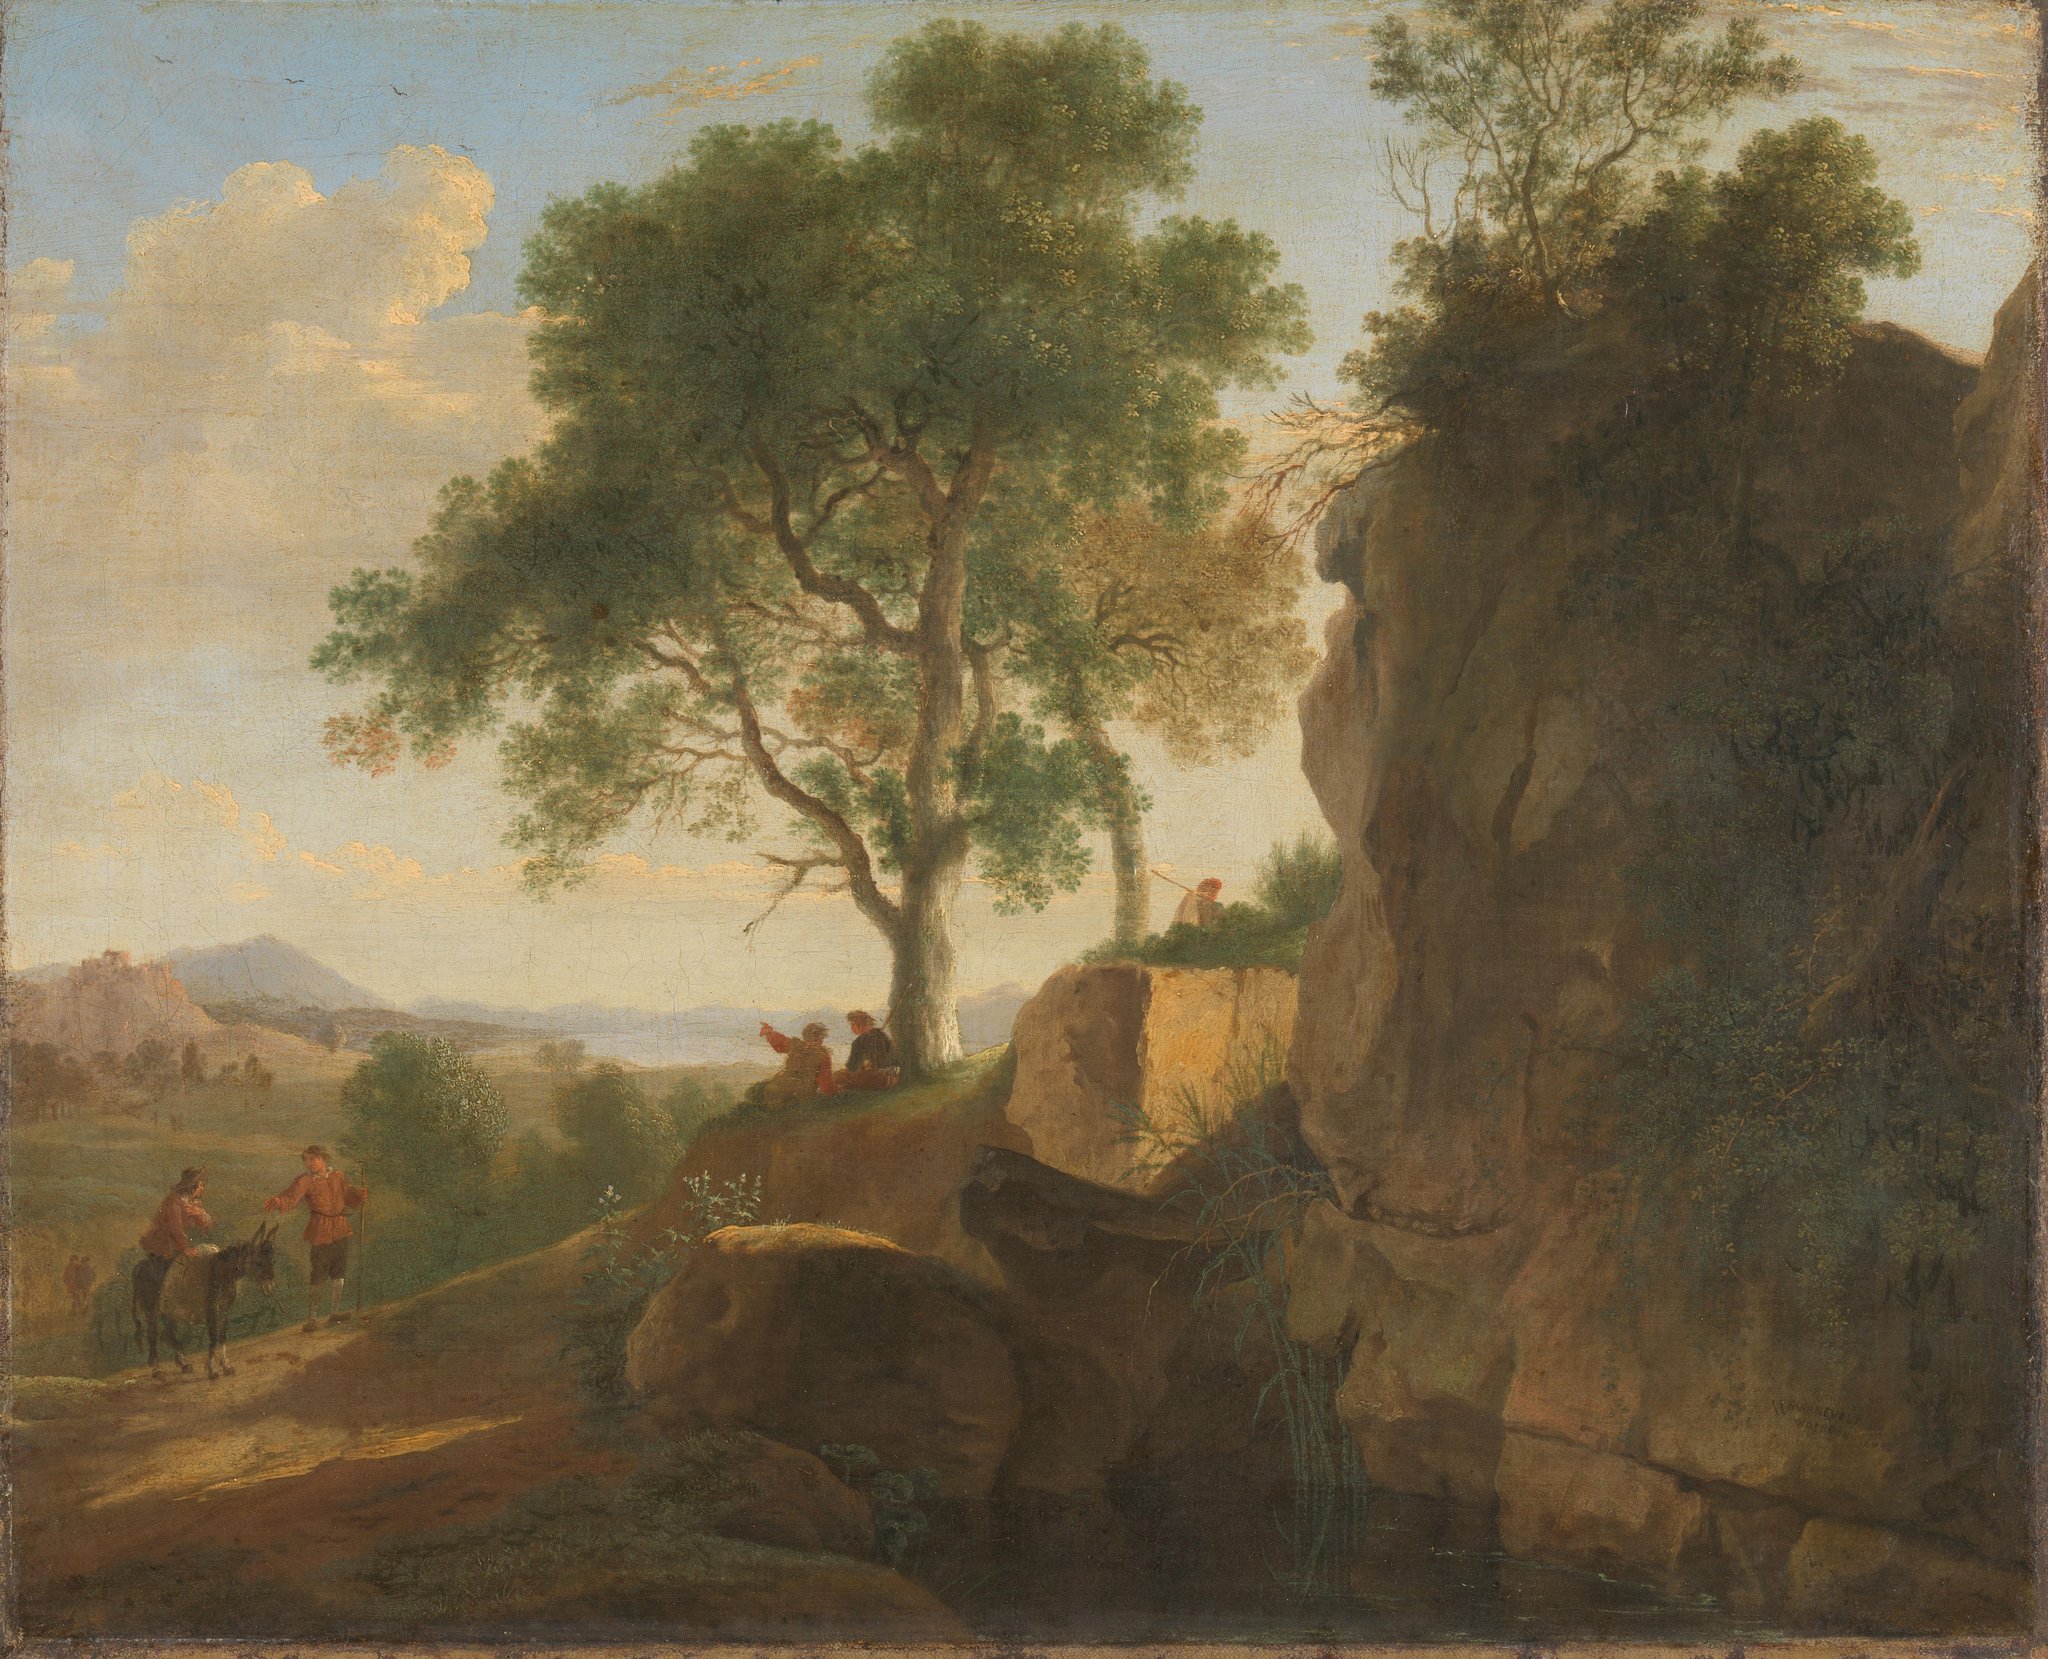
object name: painting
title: Italian landscape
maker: herman van swanevelt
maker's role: draughtsman, painter, print maker, publisher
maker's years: 1603-1655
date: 1643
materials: canvas, oil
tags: (traveller) resting in the open air, rocks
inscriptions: signature and date: ‘H. Swanevelt Fs. Woerden 1643’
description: Italiaans landschap met een zware rotspartij met bomen en een waterplas. Onder de bomen rustende reizigers, links muilezeldrijvers op een landweg.